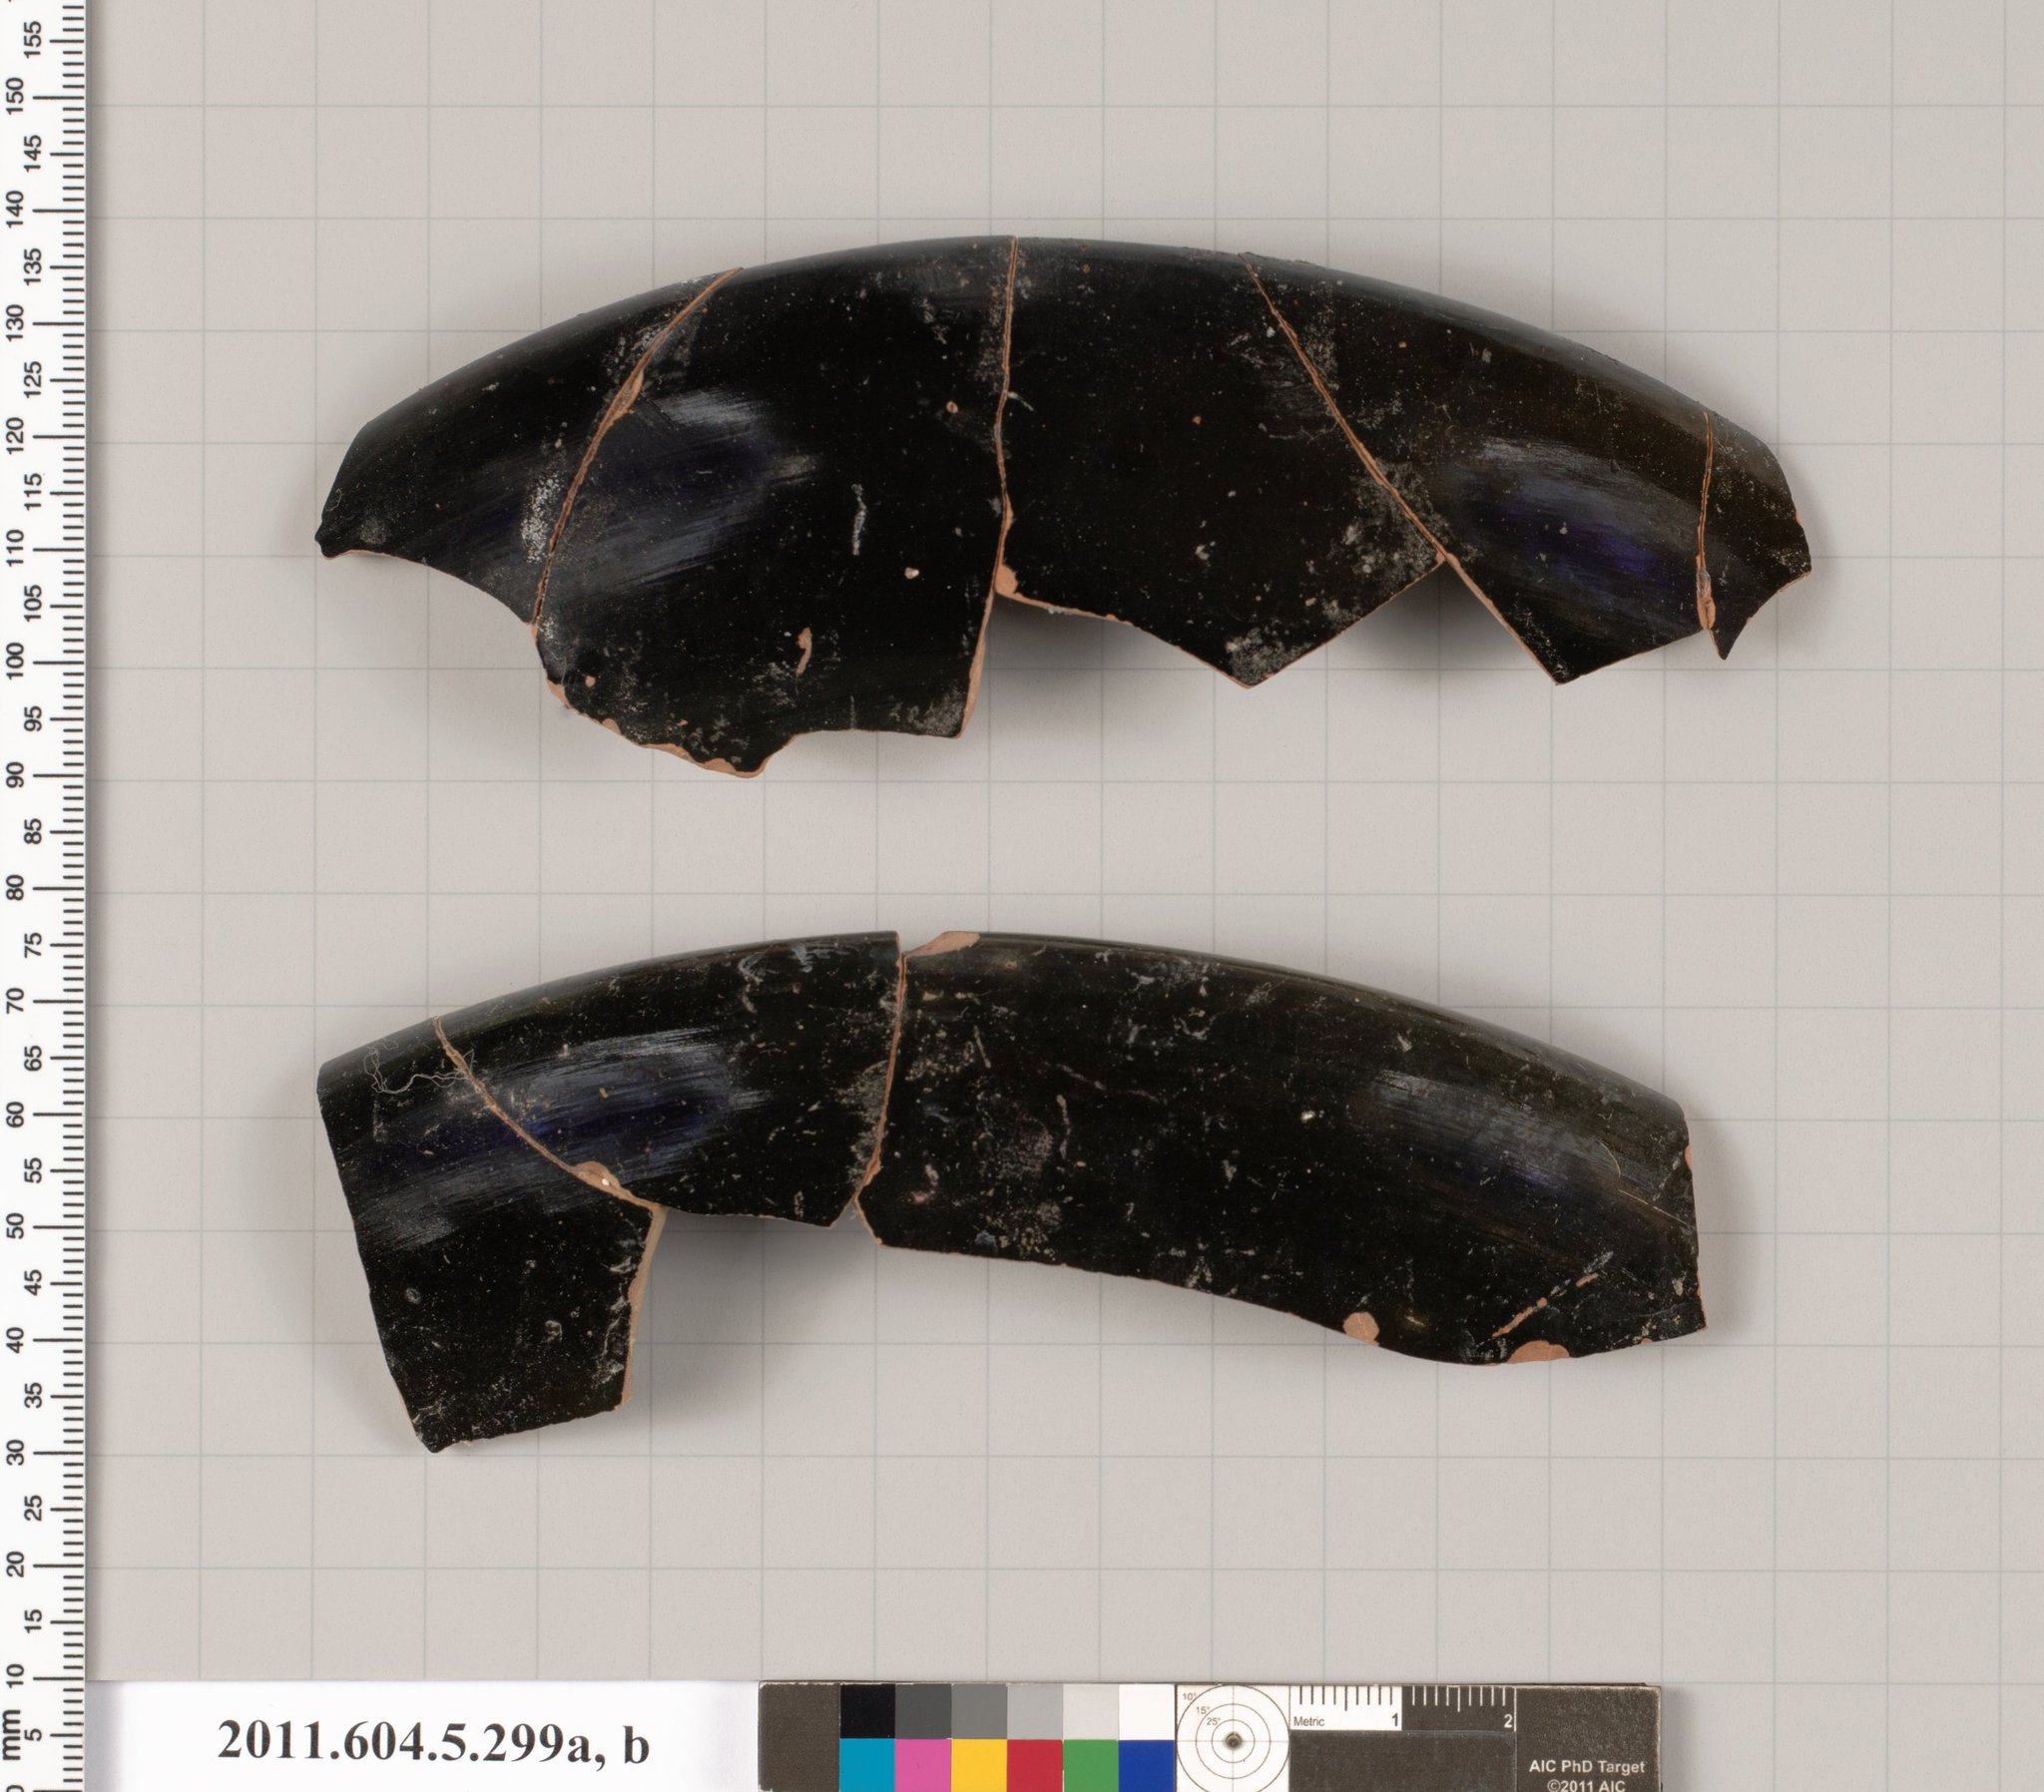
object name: kylix fragment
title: Terracotta rim fragments of kylikes (drinking cups)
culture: greek, attic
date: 600-401 BCE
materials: terracotta